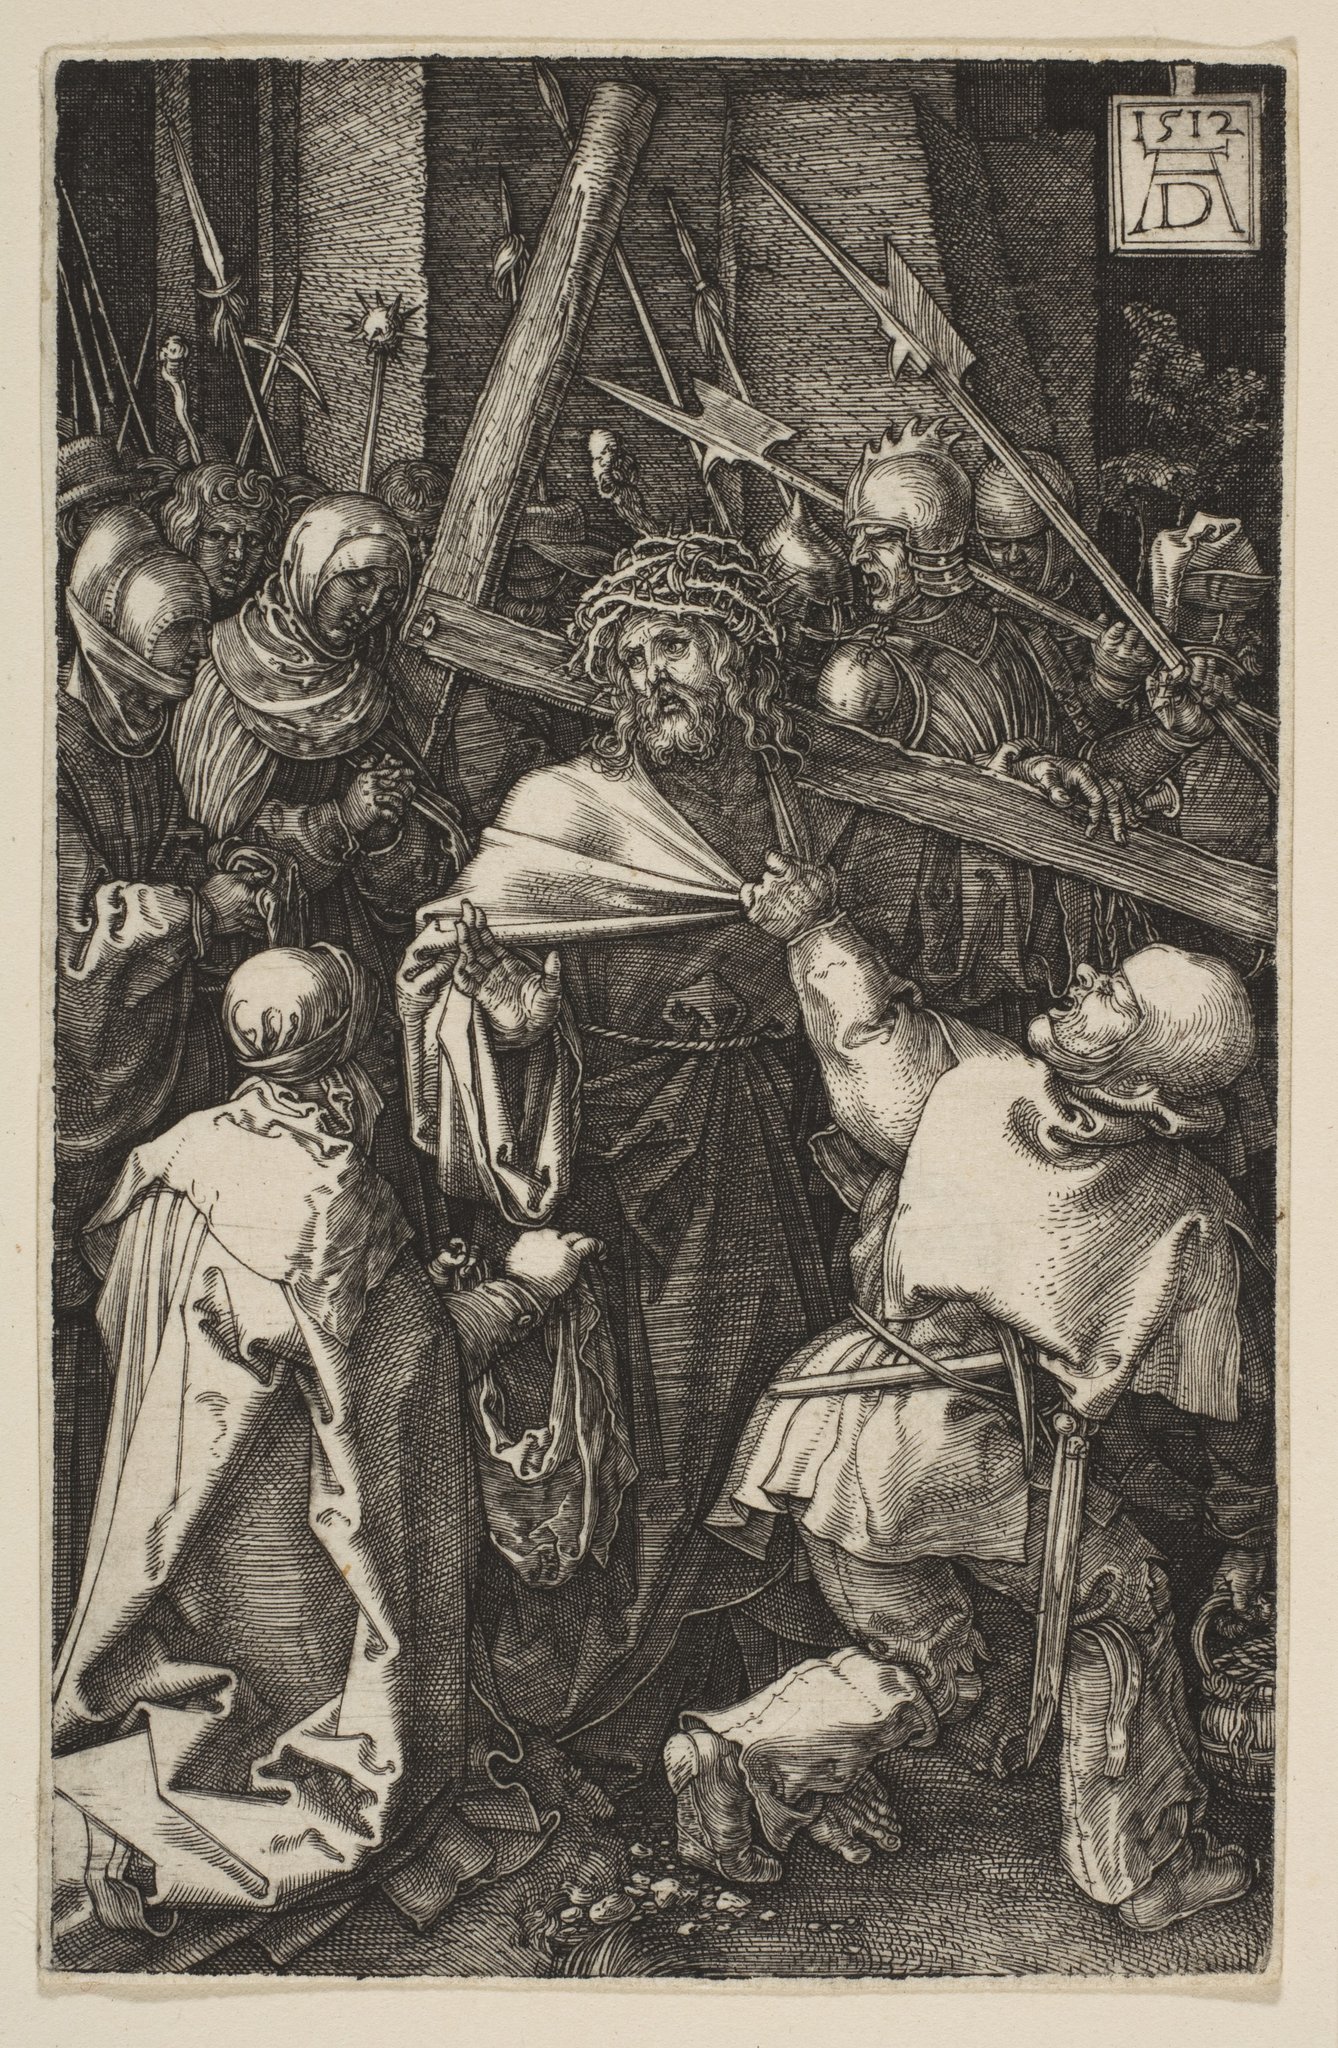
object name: print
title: Christ Carrying the Cross, from "The Passion"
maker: albrecht dürer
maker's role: artist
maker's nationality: german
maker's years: 1471-1528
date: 1512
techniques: engraving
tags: weapons,men,women,christ,cross